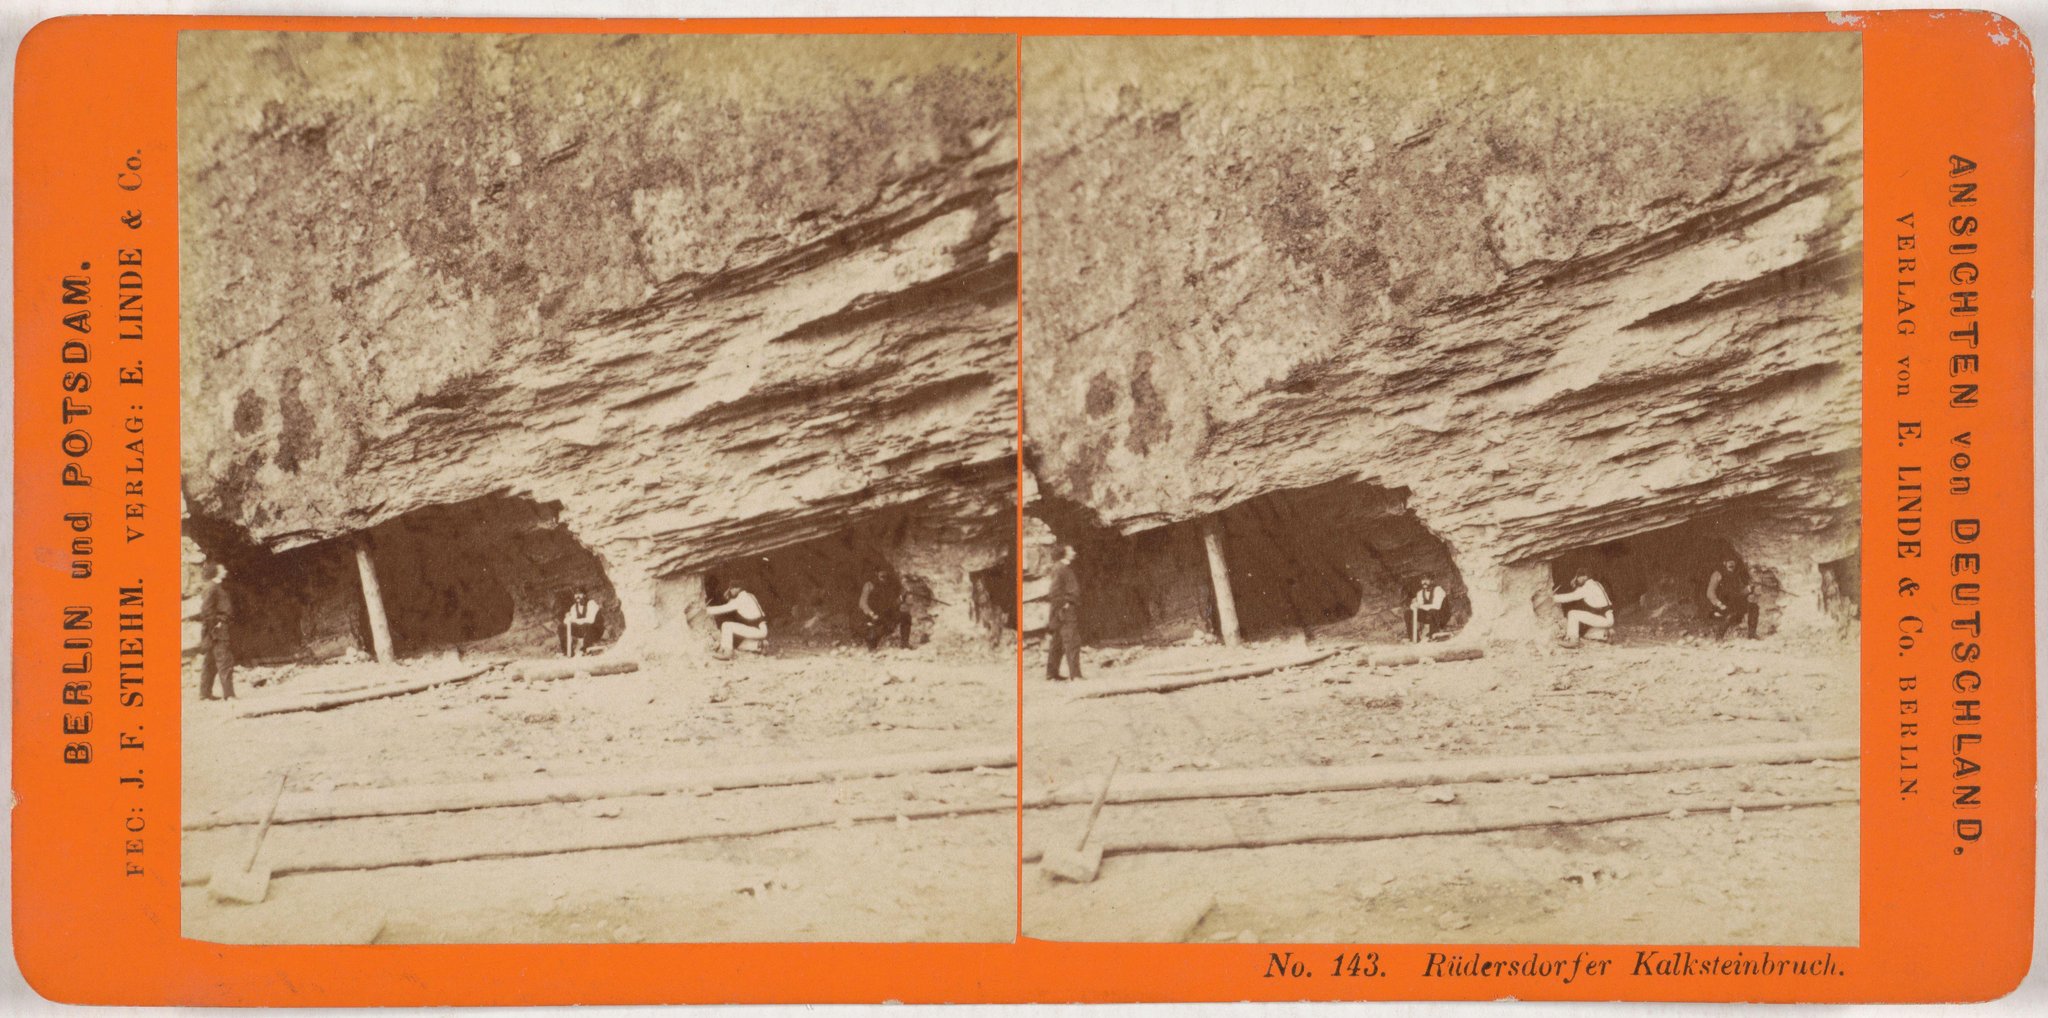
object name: stereograph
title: Rüdersdorfer Kalksteinbruch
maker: johann friedrich stiehm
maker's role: fotograaf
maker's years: 1826-1902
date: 1868-1870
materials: cardboard, paper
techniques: albumen print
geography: berlin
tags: quarry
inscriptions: number: ‘No. 143.’